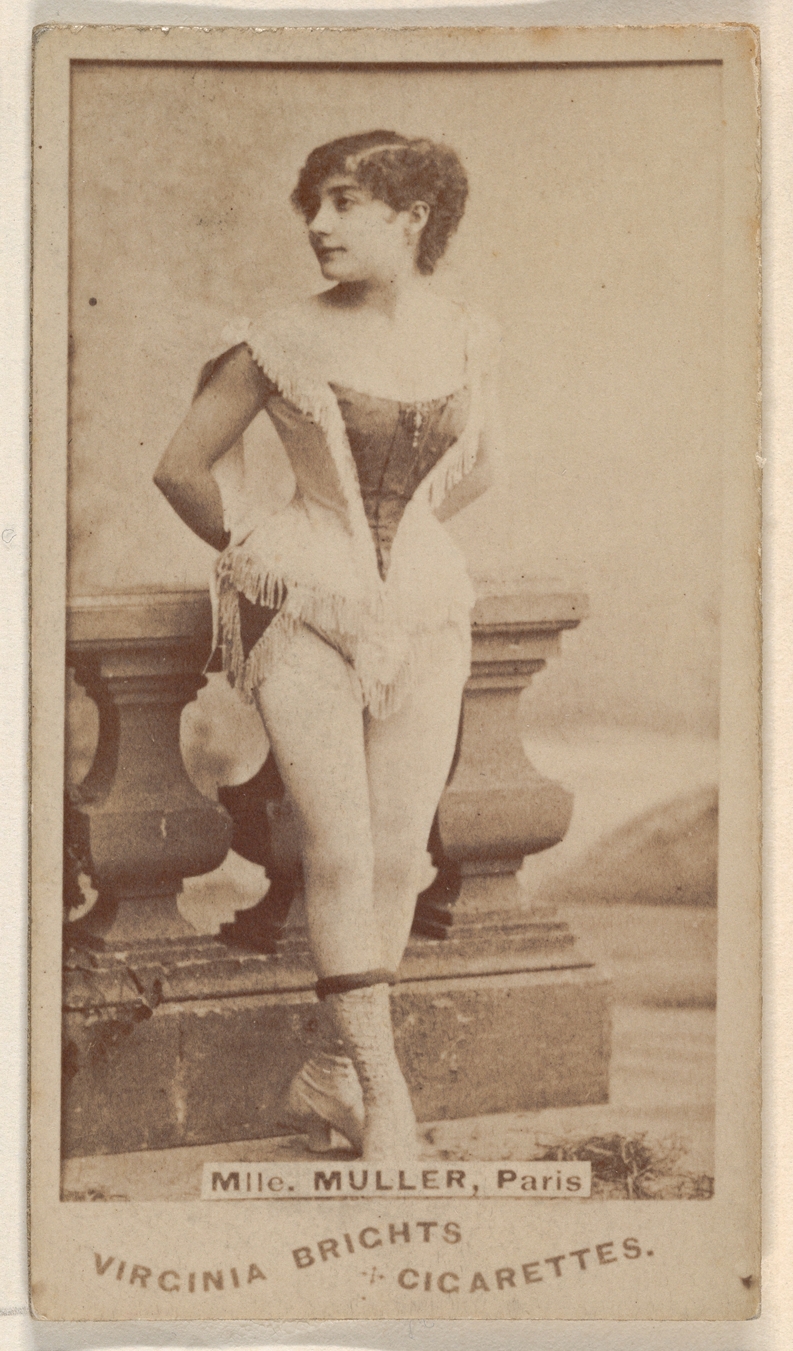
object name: photograph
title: Mlle. Muller, Paris, from the Actors and Actresses series (N45, Type 1) for Virginia Brights Cigarettes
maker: allen & ginter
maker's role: publisher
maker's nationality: american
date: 1888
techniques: albumen silver print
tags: portraits,women,actresses